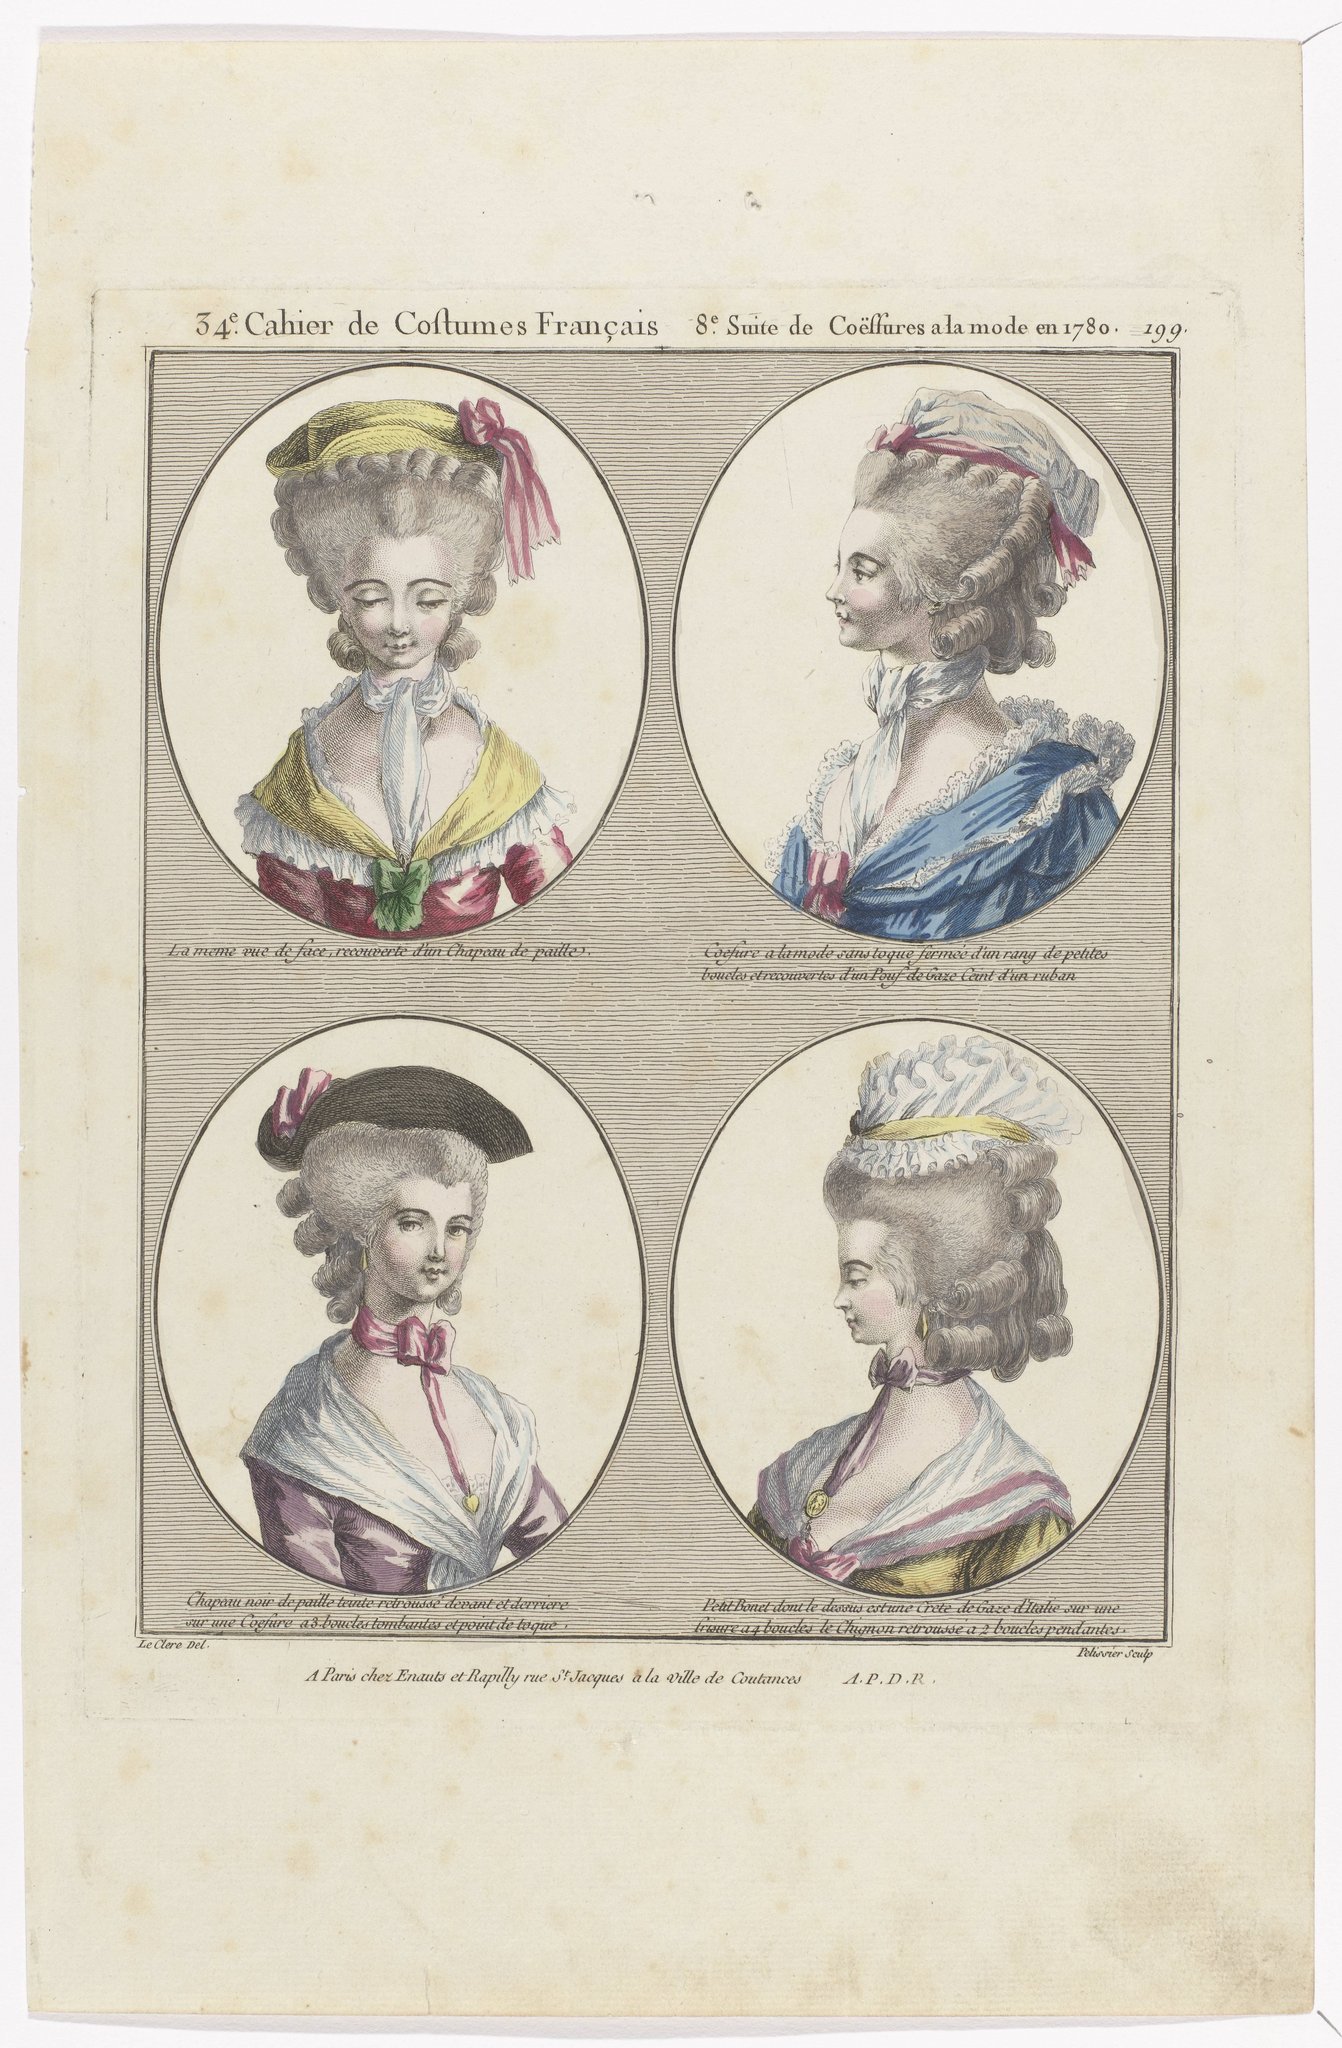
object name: fashion print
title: Coiffures, Poufs, Hats and Bonnets: Eleven Coiffures and Headdresses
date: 1780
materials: paper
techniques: engraving, hand coloring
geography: paris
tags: ear-rings (+ women's clothes), head-gear (pouf) (+ women's clothes), border, ribbon, braid (+ women's clothes), neck-gear ~ clothing (neckerchief) (+ women's clothes), head-gear (straw hat) (+ women's clothes), styles of hairdress - aa - ~ women, head-gear: cap (+ women's clothes), fashion plates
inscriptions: inscription: ‘Coefure a la mode sans toque fermée d'un rang de petites boucles et recouvertes d'un Pouf de Gaze Ceint d'un ruban.’, inscription: ‘Petit Bonet dont le dessus est une Crete de Gaze d'Italie sur une frisure a 4 boucles le Chignon retroussé a 2 boucles pendantes.’, inscription: ‘La meme vue de face, recouverte d'un Chapeau de paille.’, inscription: ‘Chapeau noir de paille teinte retroussé devant et derriere sur une Coefure a 3 boucles tombantes et point de toque.’, address: ‘A Paris chez Esnauts et Rapilly rue St. Jacques a la Ville de Coutances. A.P.D.R.’, title: ‘34e Cahier de Costumes Français 8e Suite de Coëffures a la mode en 1780.’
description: Ladies’ hairstyles were ingenious works of art, built around a core of cushions and horsehair. Hair was piled high in curls and twists (chignons) and adorned with feathers, ribbons, artificial flowers, tulle and jewels to create various fancifully named poufs. Because the hair was dressed using animal fat and powdered with wheat flour, these poufs attracted all manner of insects. Far from hygienic, they moreover did not last long. When they went out, ladies protected their hairdos with a voluminous ribbed hood called a calèche 1. Hairdressers of the time, who styled themselves as artists, used prints to advertise their latest creations and craftsmanship 2 3.